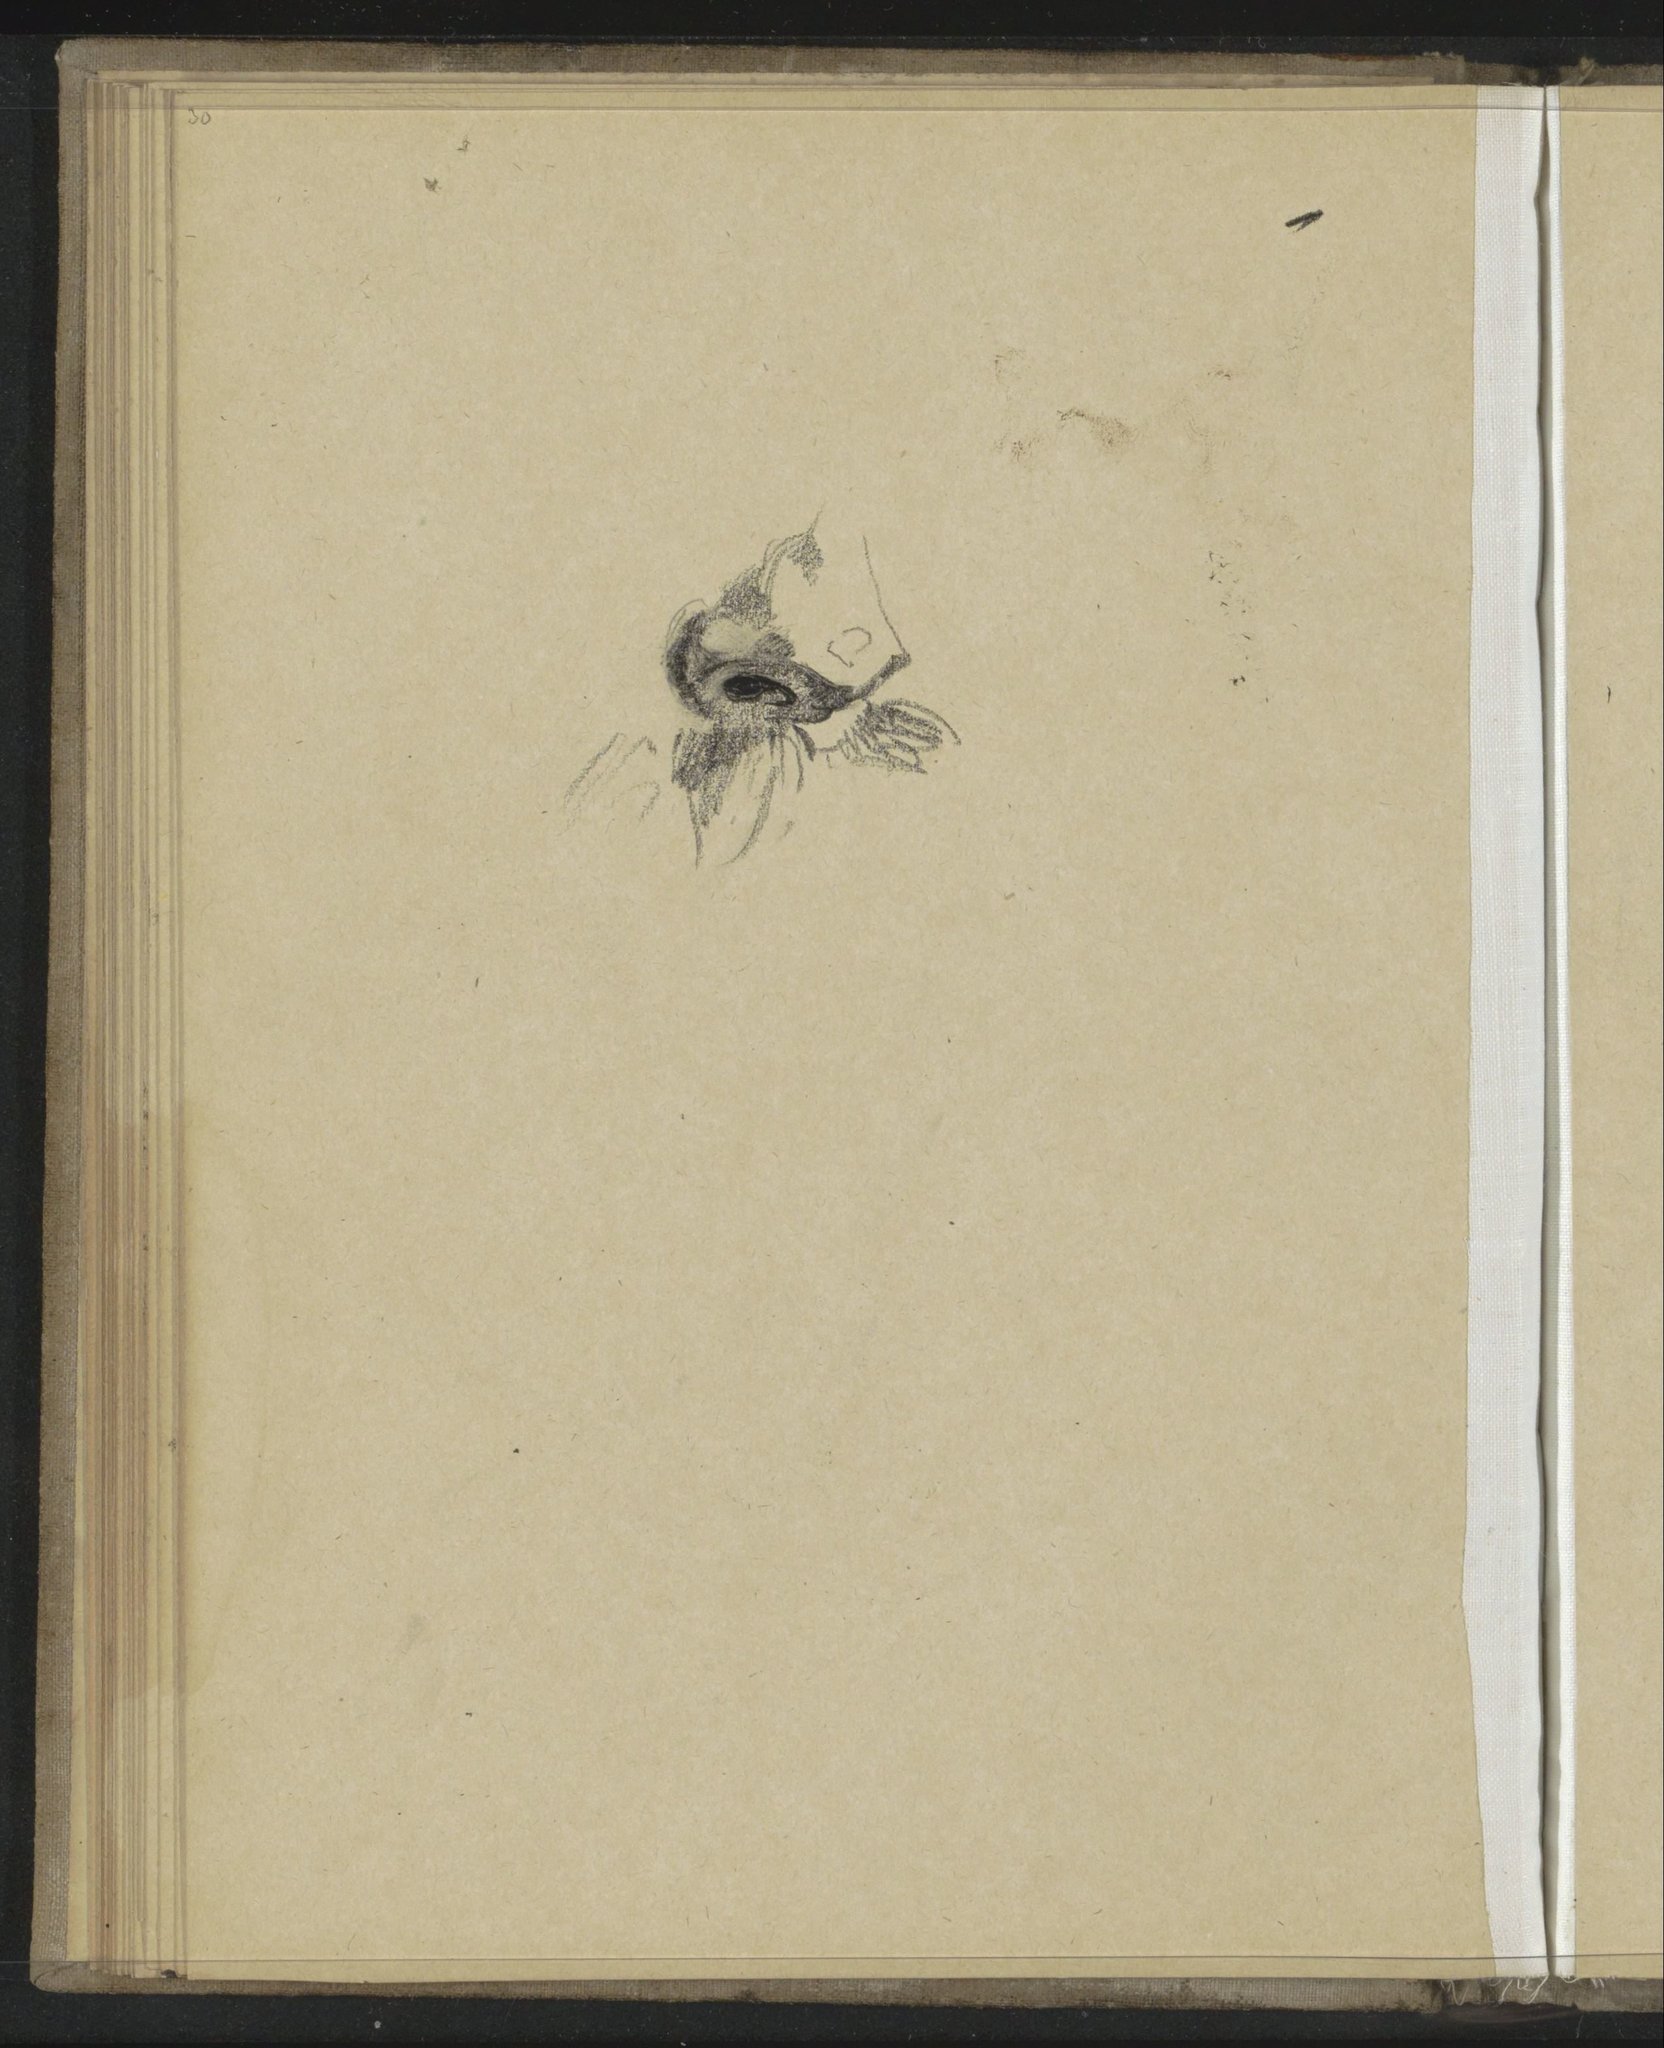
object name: sketchbook leaf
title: Studie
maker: willem witsen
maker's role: draughtsman, painter, print maker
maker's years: 1860-1923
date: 1892-1897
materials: paper, pencil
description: Pagina 30 uit een schetsboek met 24 bladen.